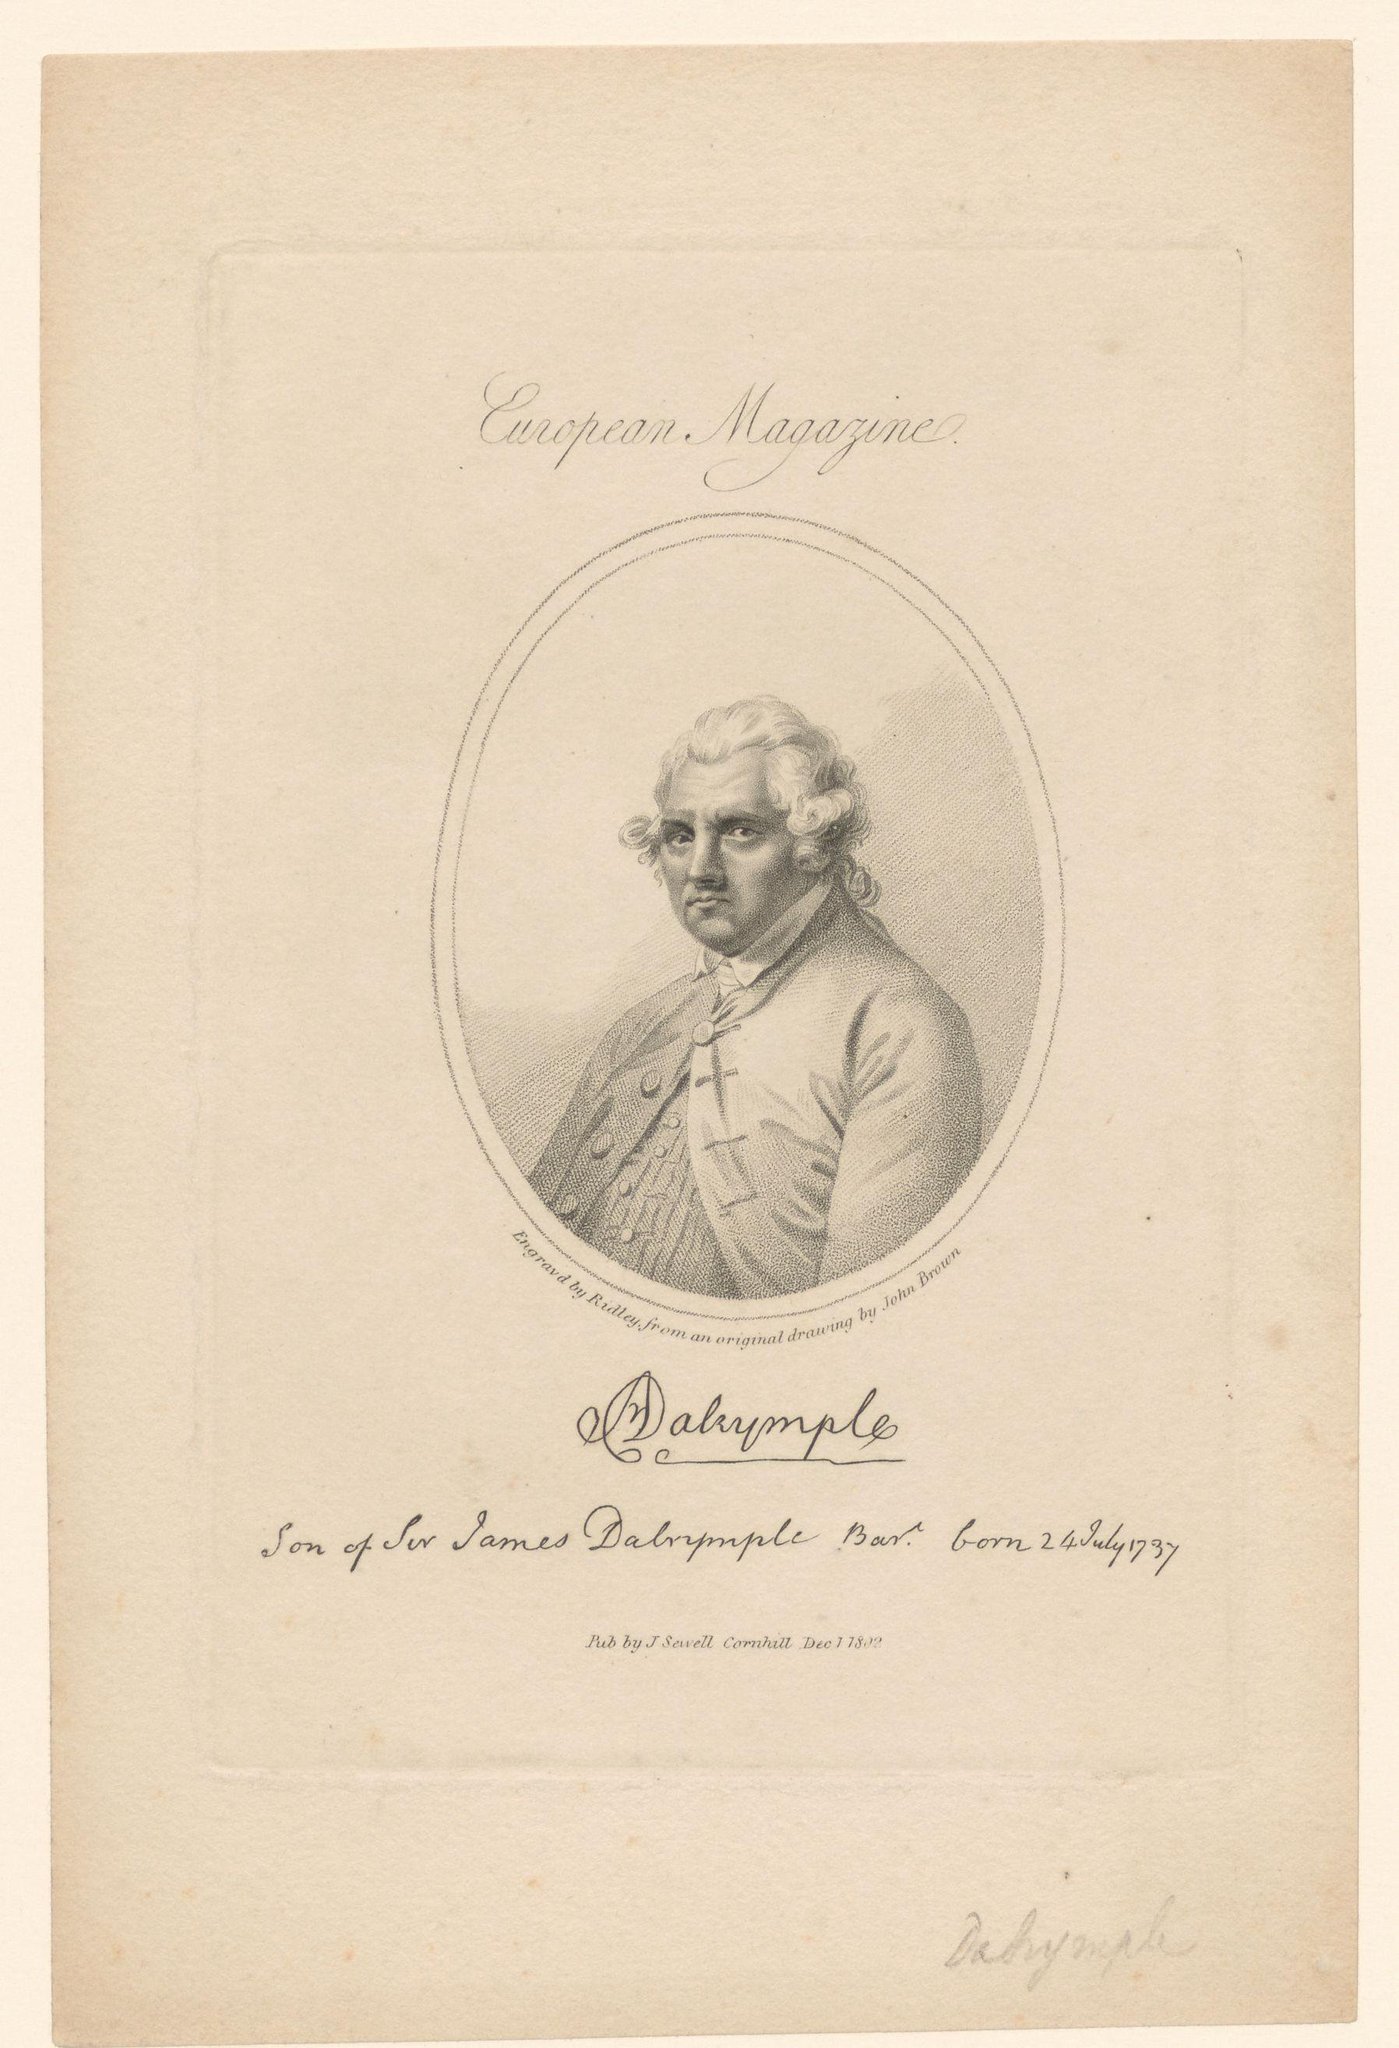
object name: print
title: Portret van Alexander Dalrymple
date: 1802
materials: paper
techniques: stippling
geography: london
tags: london, historical persons, explorer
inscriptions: collector's mark: Lugt 2228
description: Tekst en een facsimile signatuur in de ondermarge.